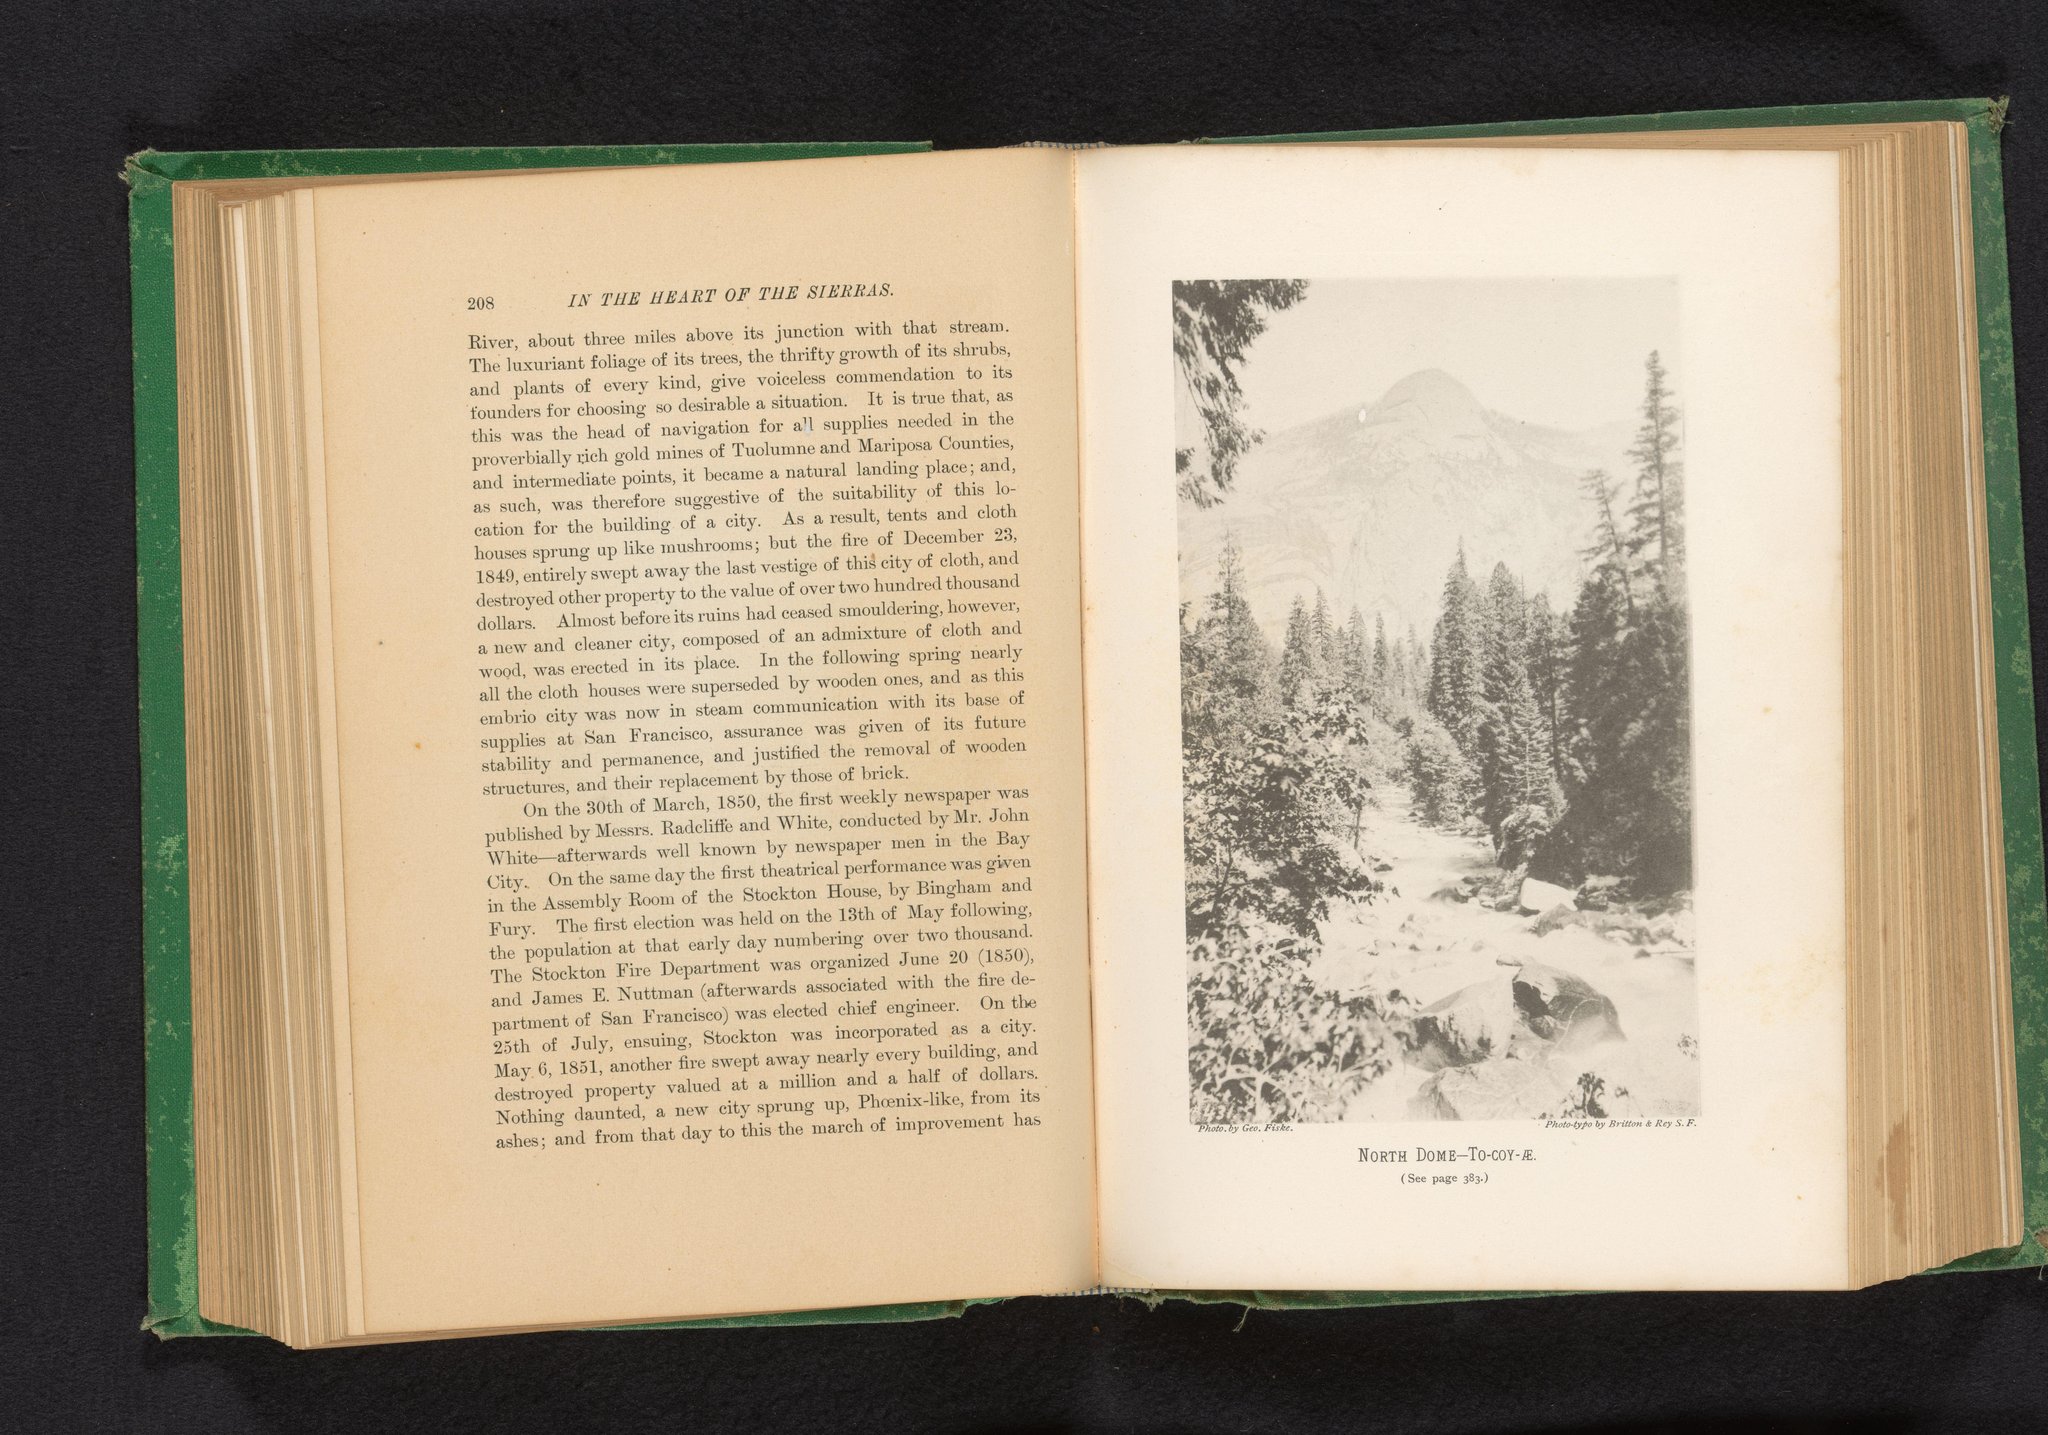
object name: photomechanical print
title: North Dome - To-coy-ae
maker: george fiske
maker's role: fotograaf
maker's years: 1835-1918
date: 1881-1886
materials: paper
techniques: photograph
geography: yosemite valley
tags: mountain-range, snow peaks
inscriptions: number: ‘431.’, inscription: ‘(See page 383.)’